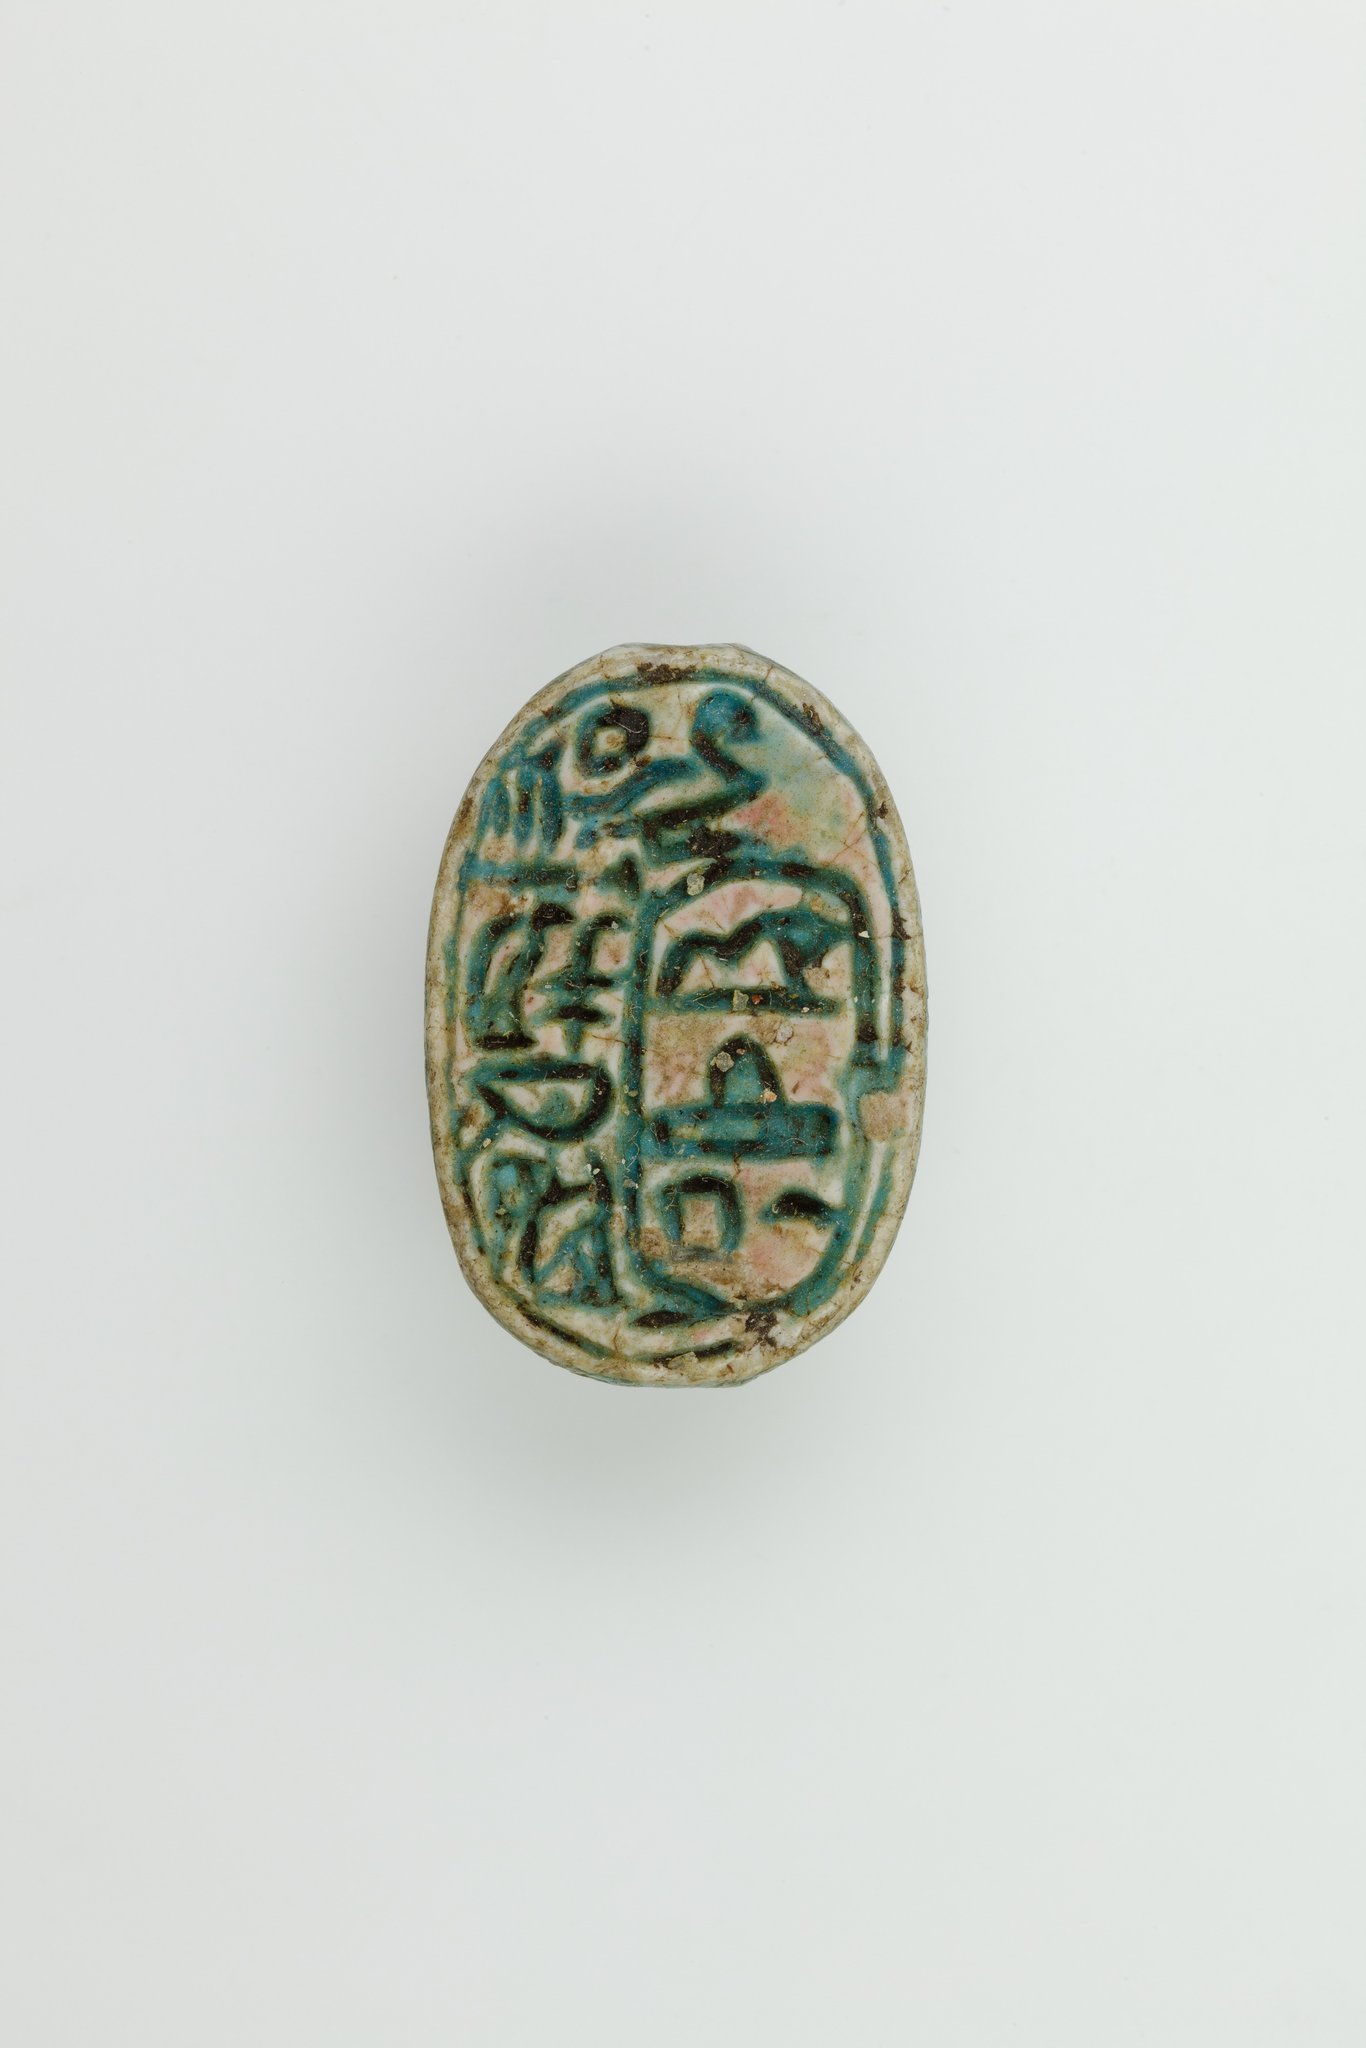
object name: scarab, khaneferre sebekhotep iv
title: Scarab of King Khaneferre Sebekhotep IV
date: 1731-1719 BCE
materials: stone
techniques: glazing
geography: egypt